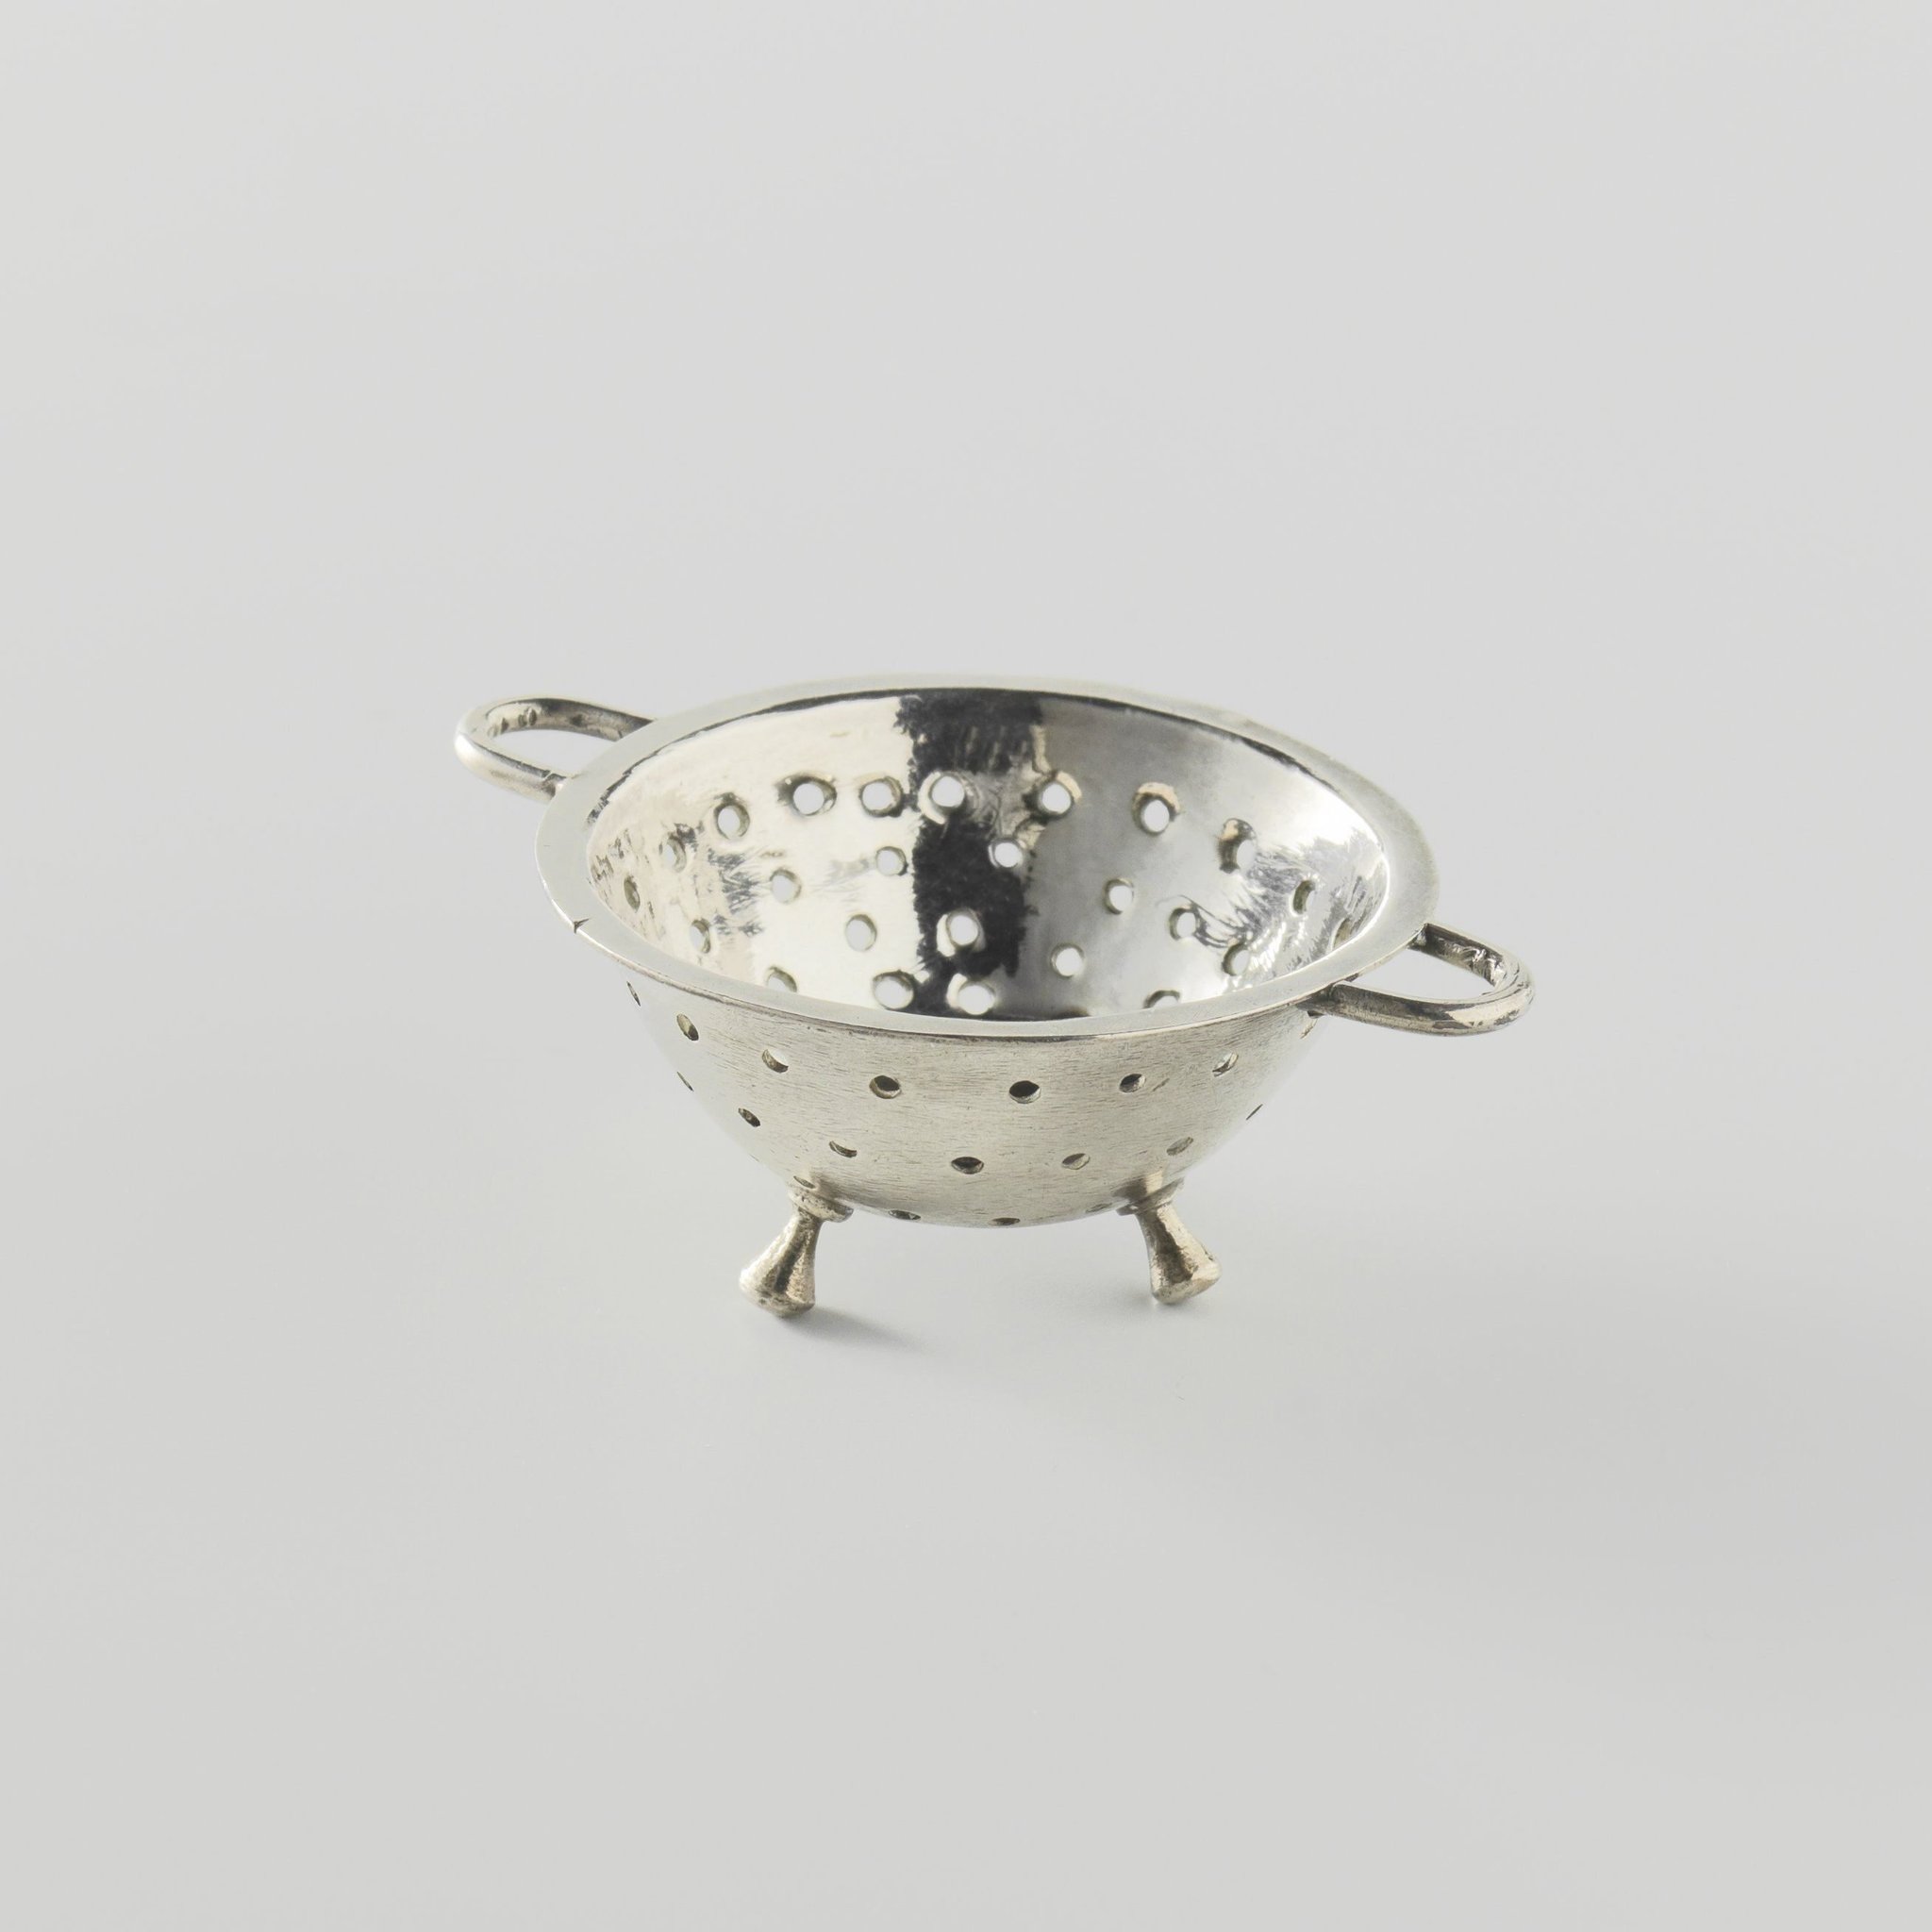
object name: miniature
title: Vergiet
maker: Anonymous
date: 1738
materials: silver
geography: amsterdam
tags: kitchen-utensils: colander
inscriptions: date letter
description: Rond vergiet op drie poten met twee liggende c-vormige handvatten. Het vergiet is gemerkt: stk.= Amsterdam, jrl.= D (1738) en een onleesbaar meesterteken.